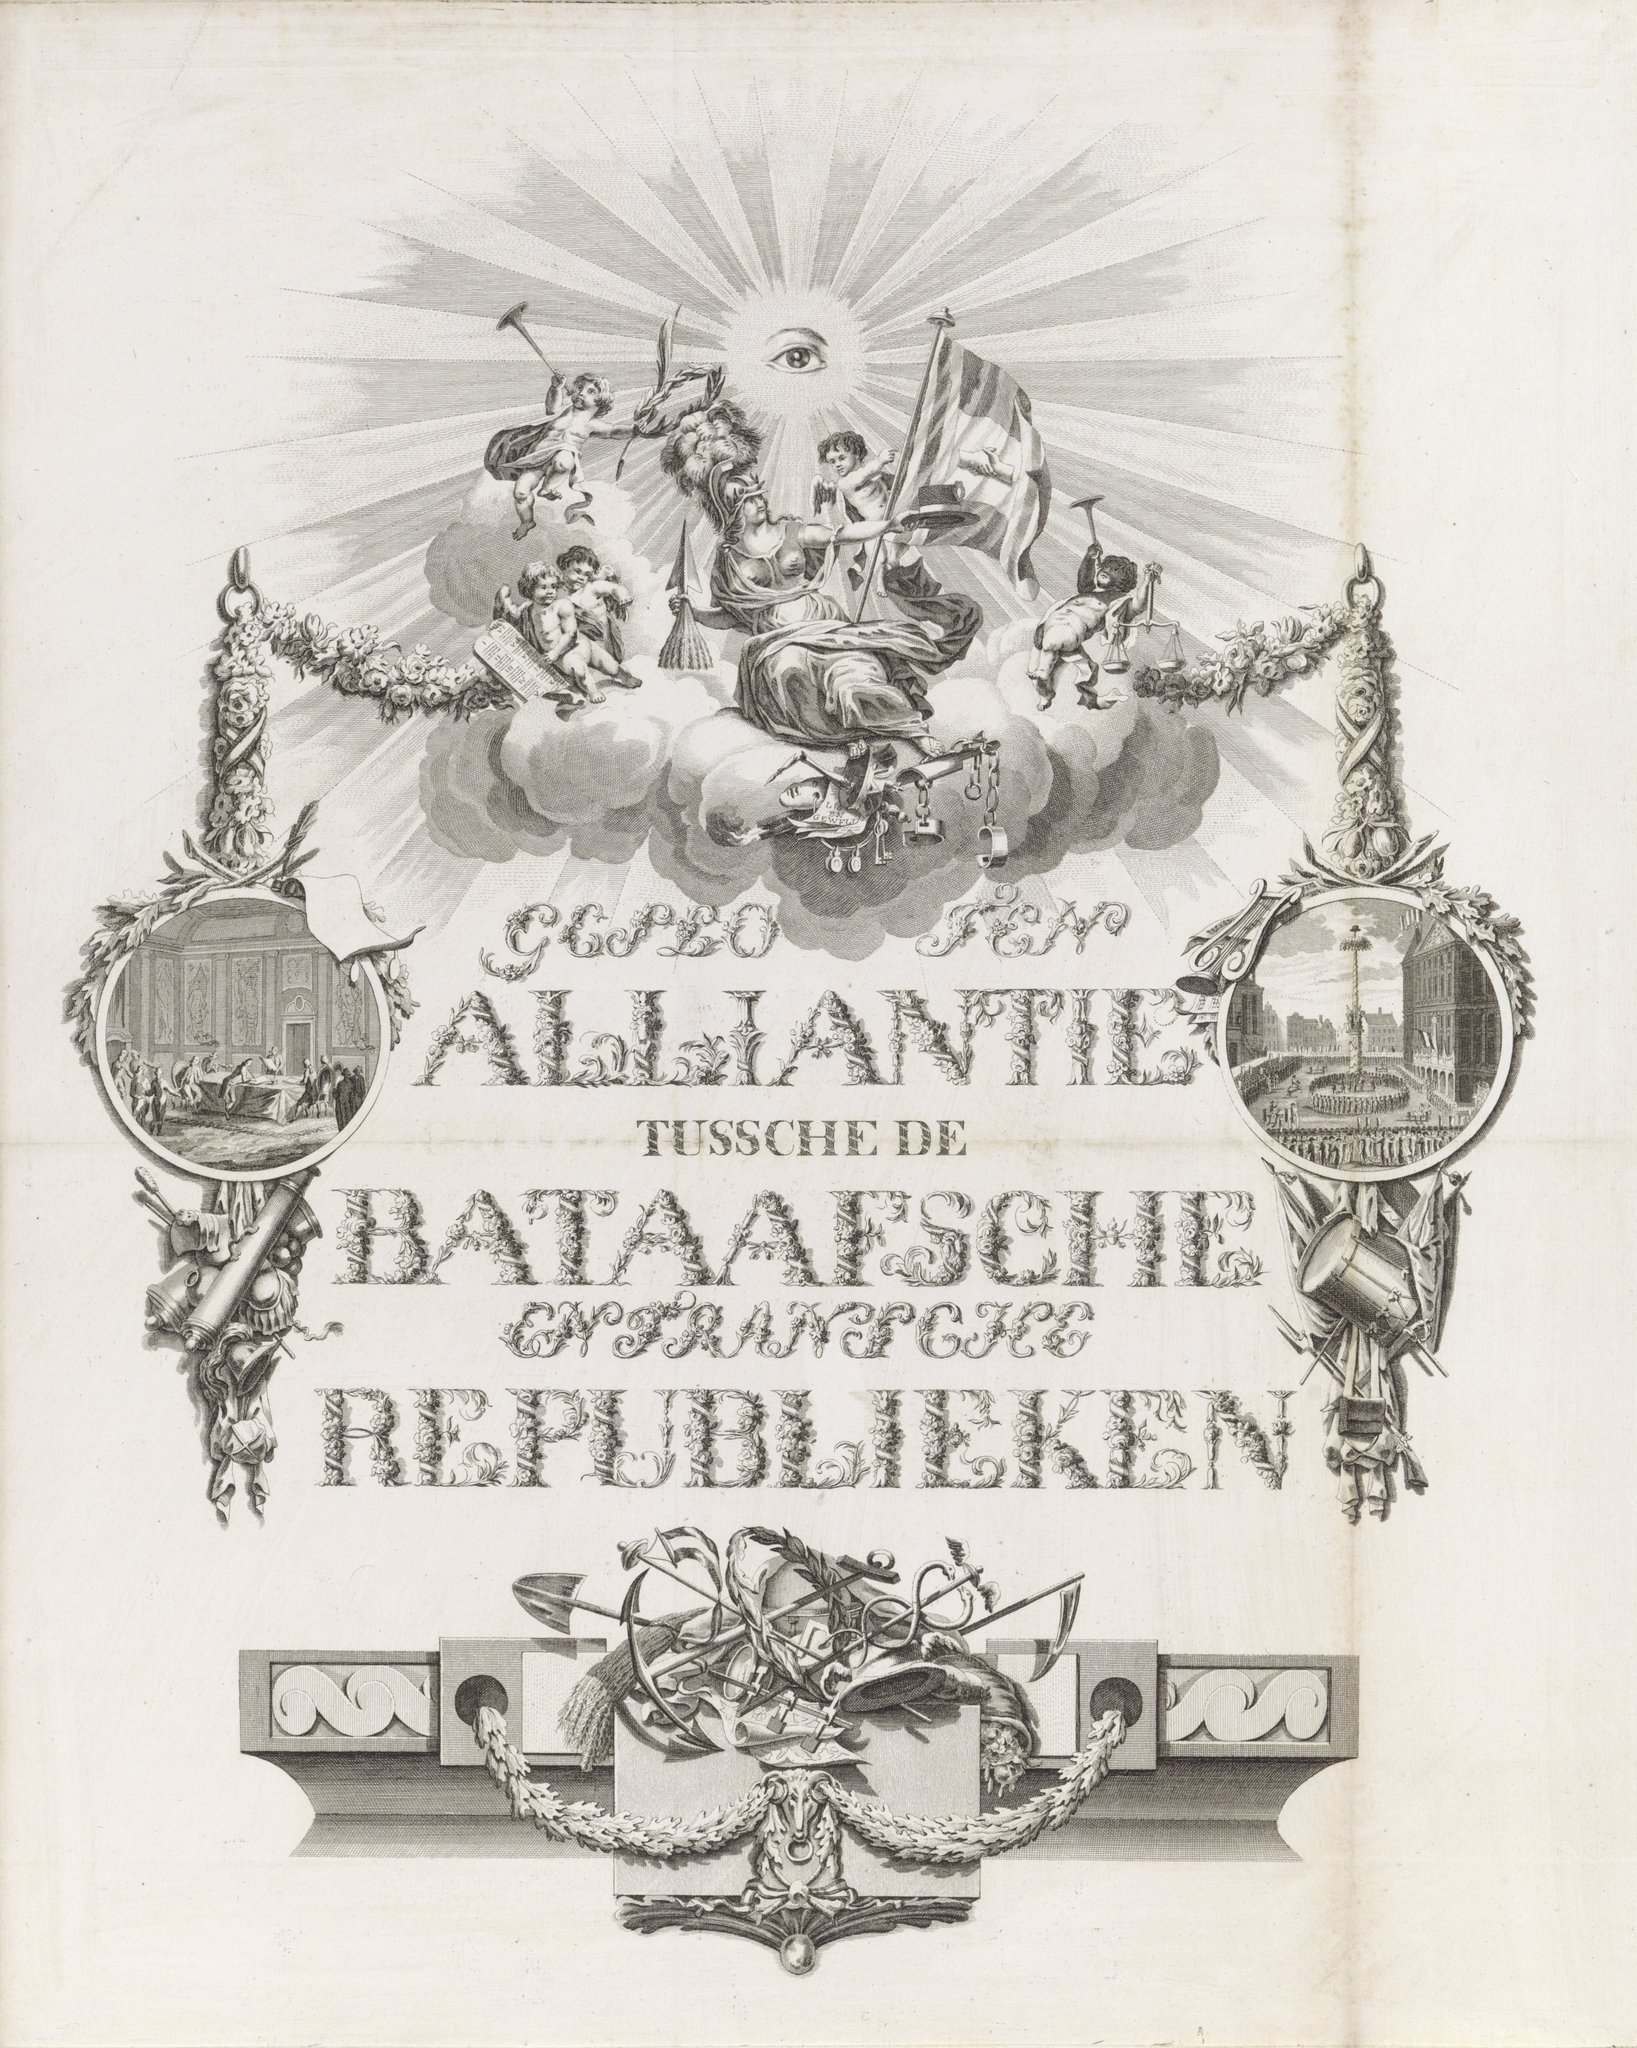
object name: print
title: Gesloten Alliantie tussche de Bataafsche en Fransche Republieken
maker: jan lucas van der beek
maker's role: draughtsman, print maker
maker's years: 1753-1818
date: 1795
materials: paper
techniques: engraving, etching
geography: netherlands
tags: announcement, proclamation of laws, calligraphy, the all-seeing eye, triangle with eye ~ symbol of god the father, freedom, liberty; 'libertà' (ripa) (+ abstract concept represented by female figure), dancing around the tree of liberty, alliance with france (1795)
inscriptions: collector's mark: Lugt 2228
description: Allegorie op de alliantie gesloten tussen de Franse en de Bataafse Republiek. Kalligrafisch opschrift tussen twee medaillons met links het tekenen van de alliantie in Den Haag op 16 mei 1795 en rechts het alliantiefeest op de Dam op 19 juni 1795. Bovenaan troont de Vrijheid stralend in de hemel, onderaan een trofee van werktuigen en symbolen van de kunsten, wetenschappen, handel en zeevaart.